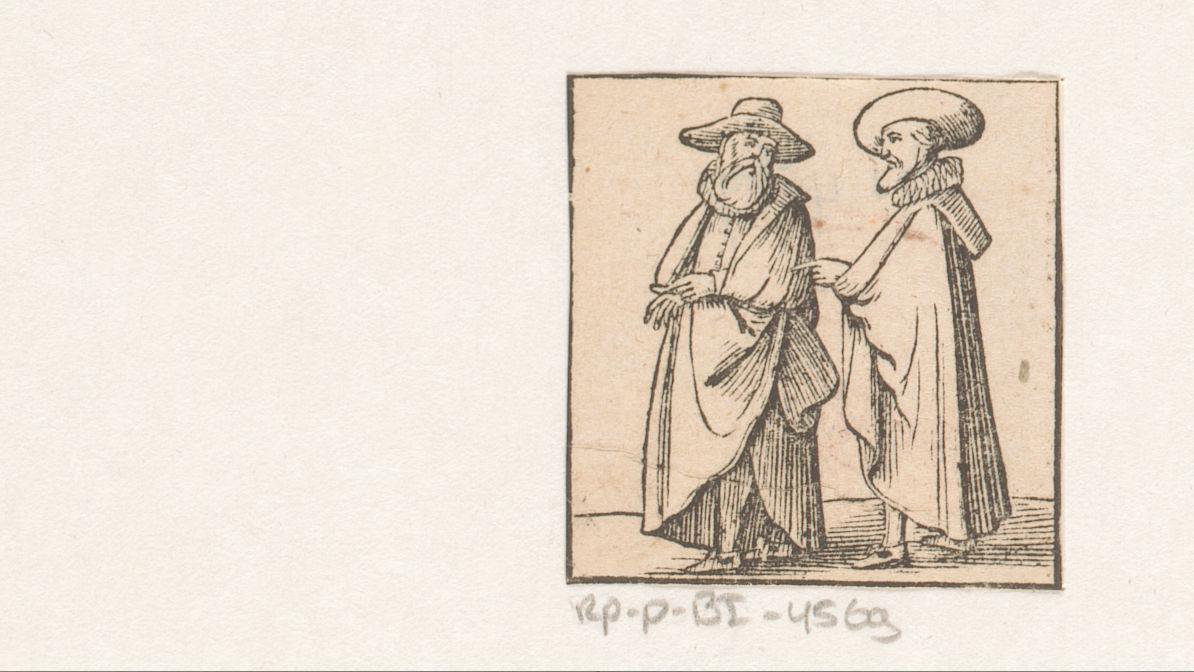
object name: print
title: Twee staande mannen met hoeden en capes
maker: Anonymous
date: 1600-1699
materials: paper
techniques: woodcut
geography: netherlands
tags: head-gear, cape, adult man (+ standing)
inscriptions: collector's mark: Lugt 240